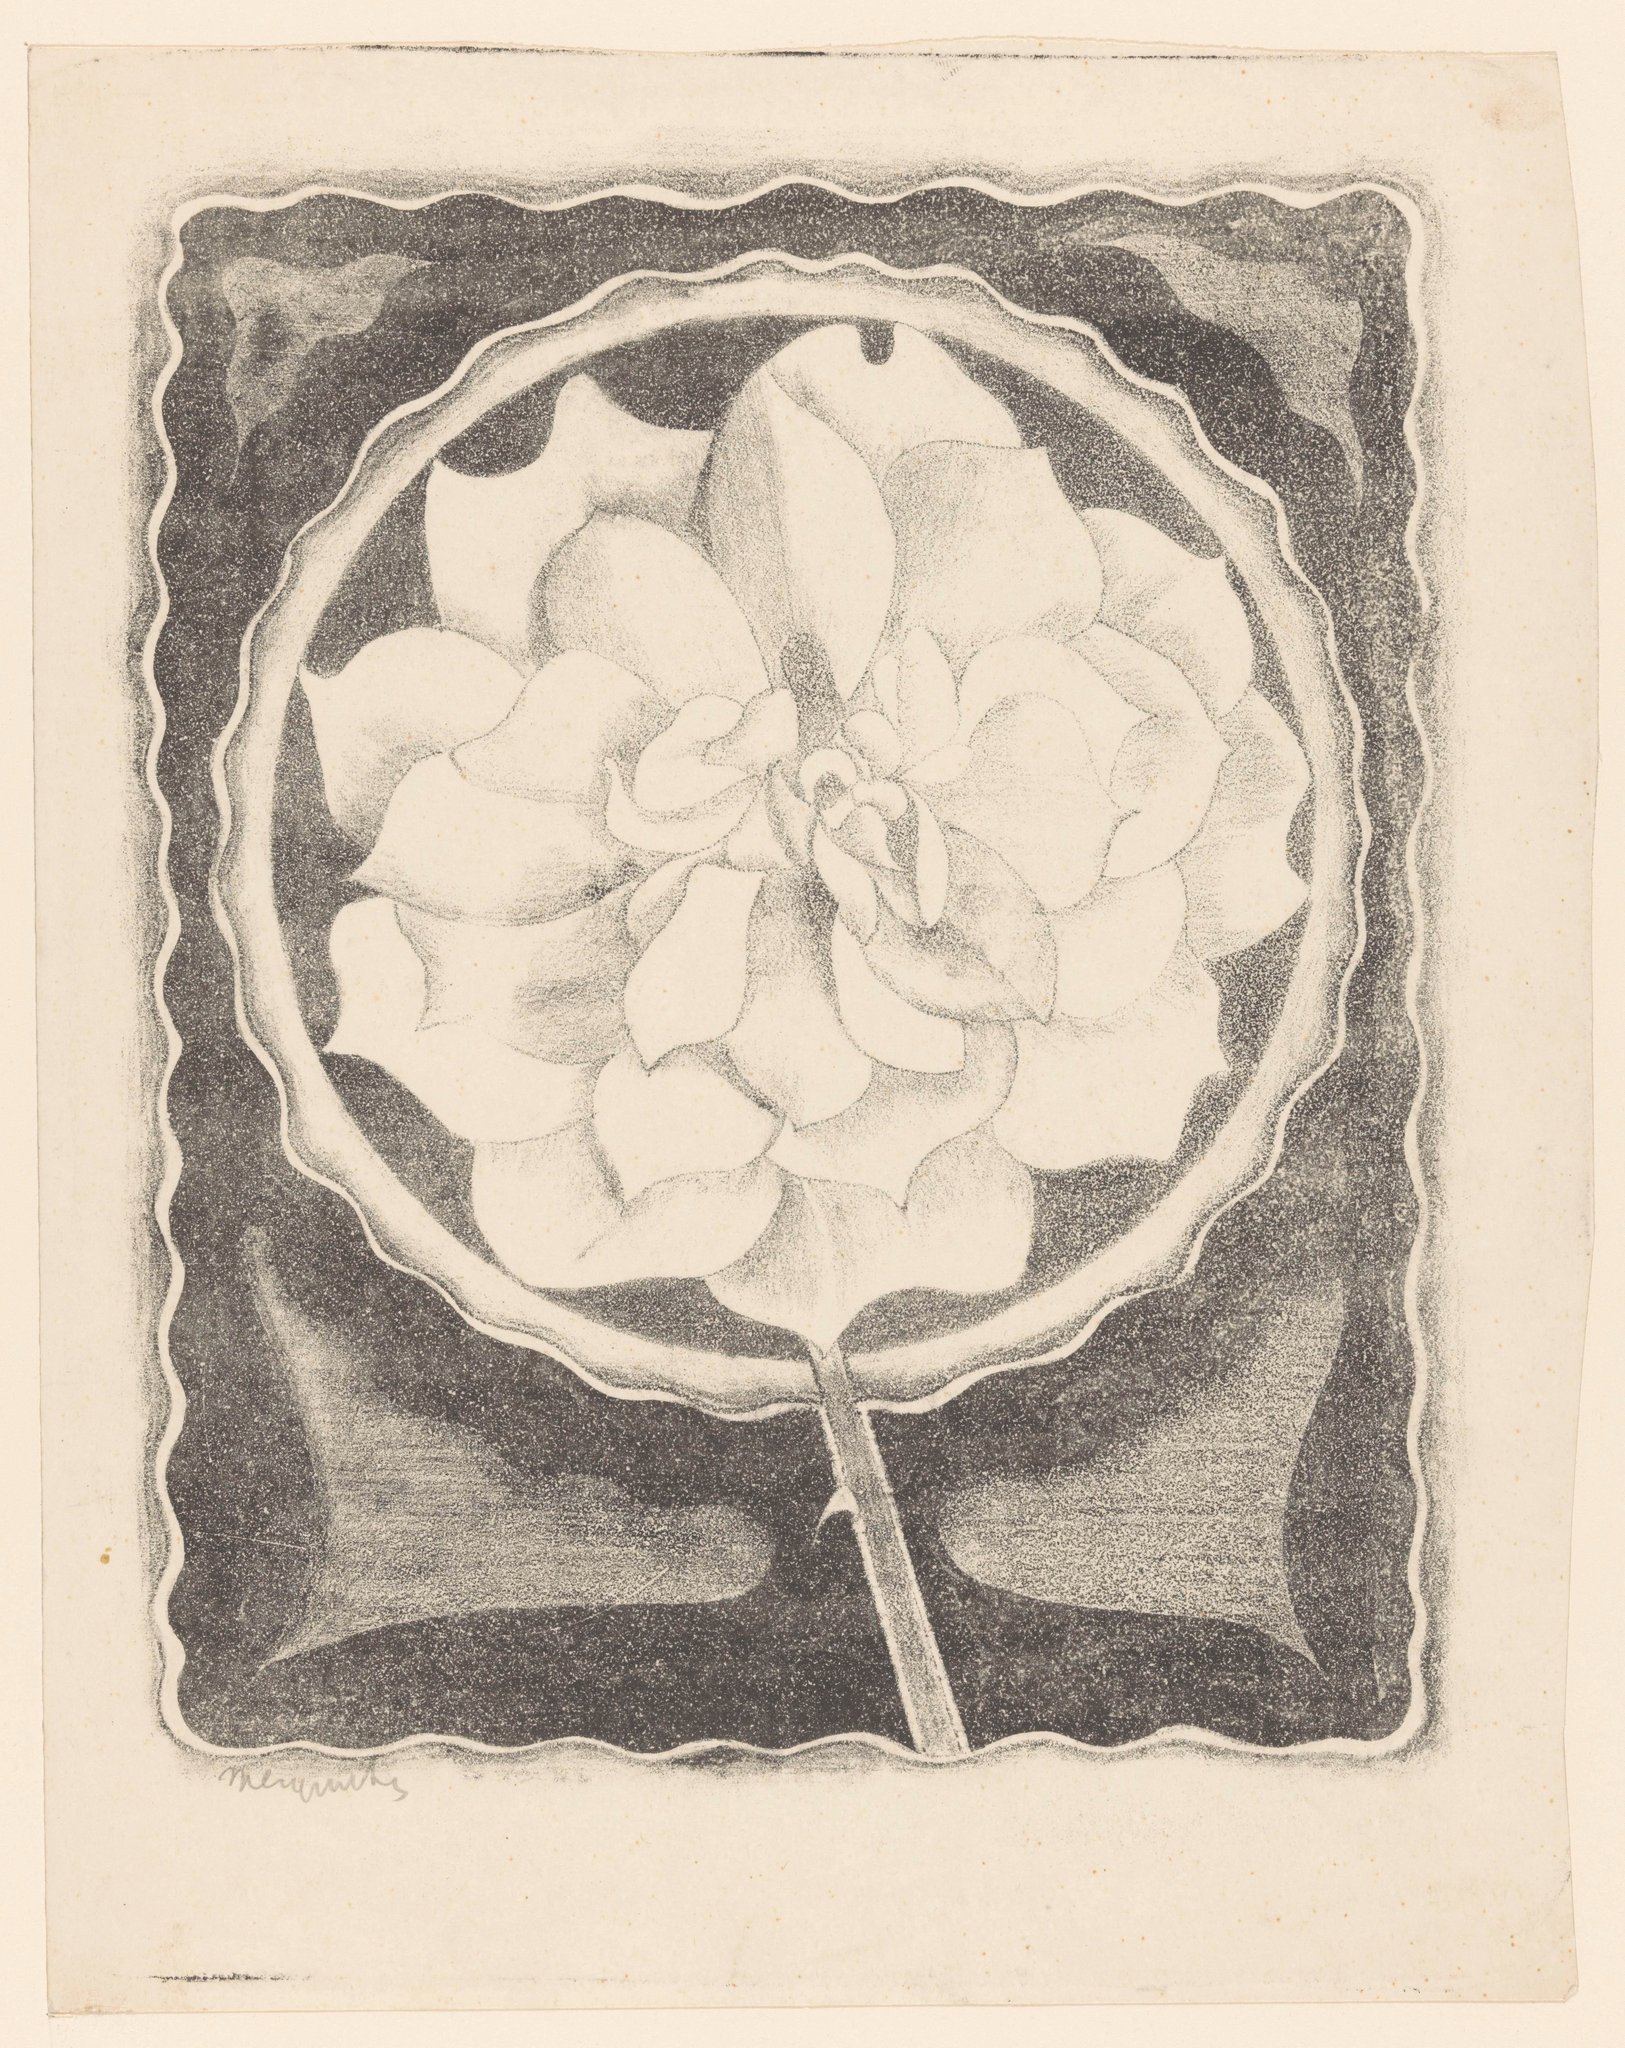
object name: print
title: Roos (in cirkel, met golvende rand)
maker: samuel jessurun de mesquita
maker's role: draughtsman, print maker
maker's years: 1868-1944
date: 1920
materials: paper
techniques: lithograph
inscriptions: signature: ‘mesquita’